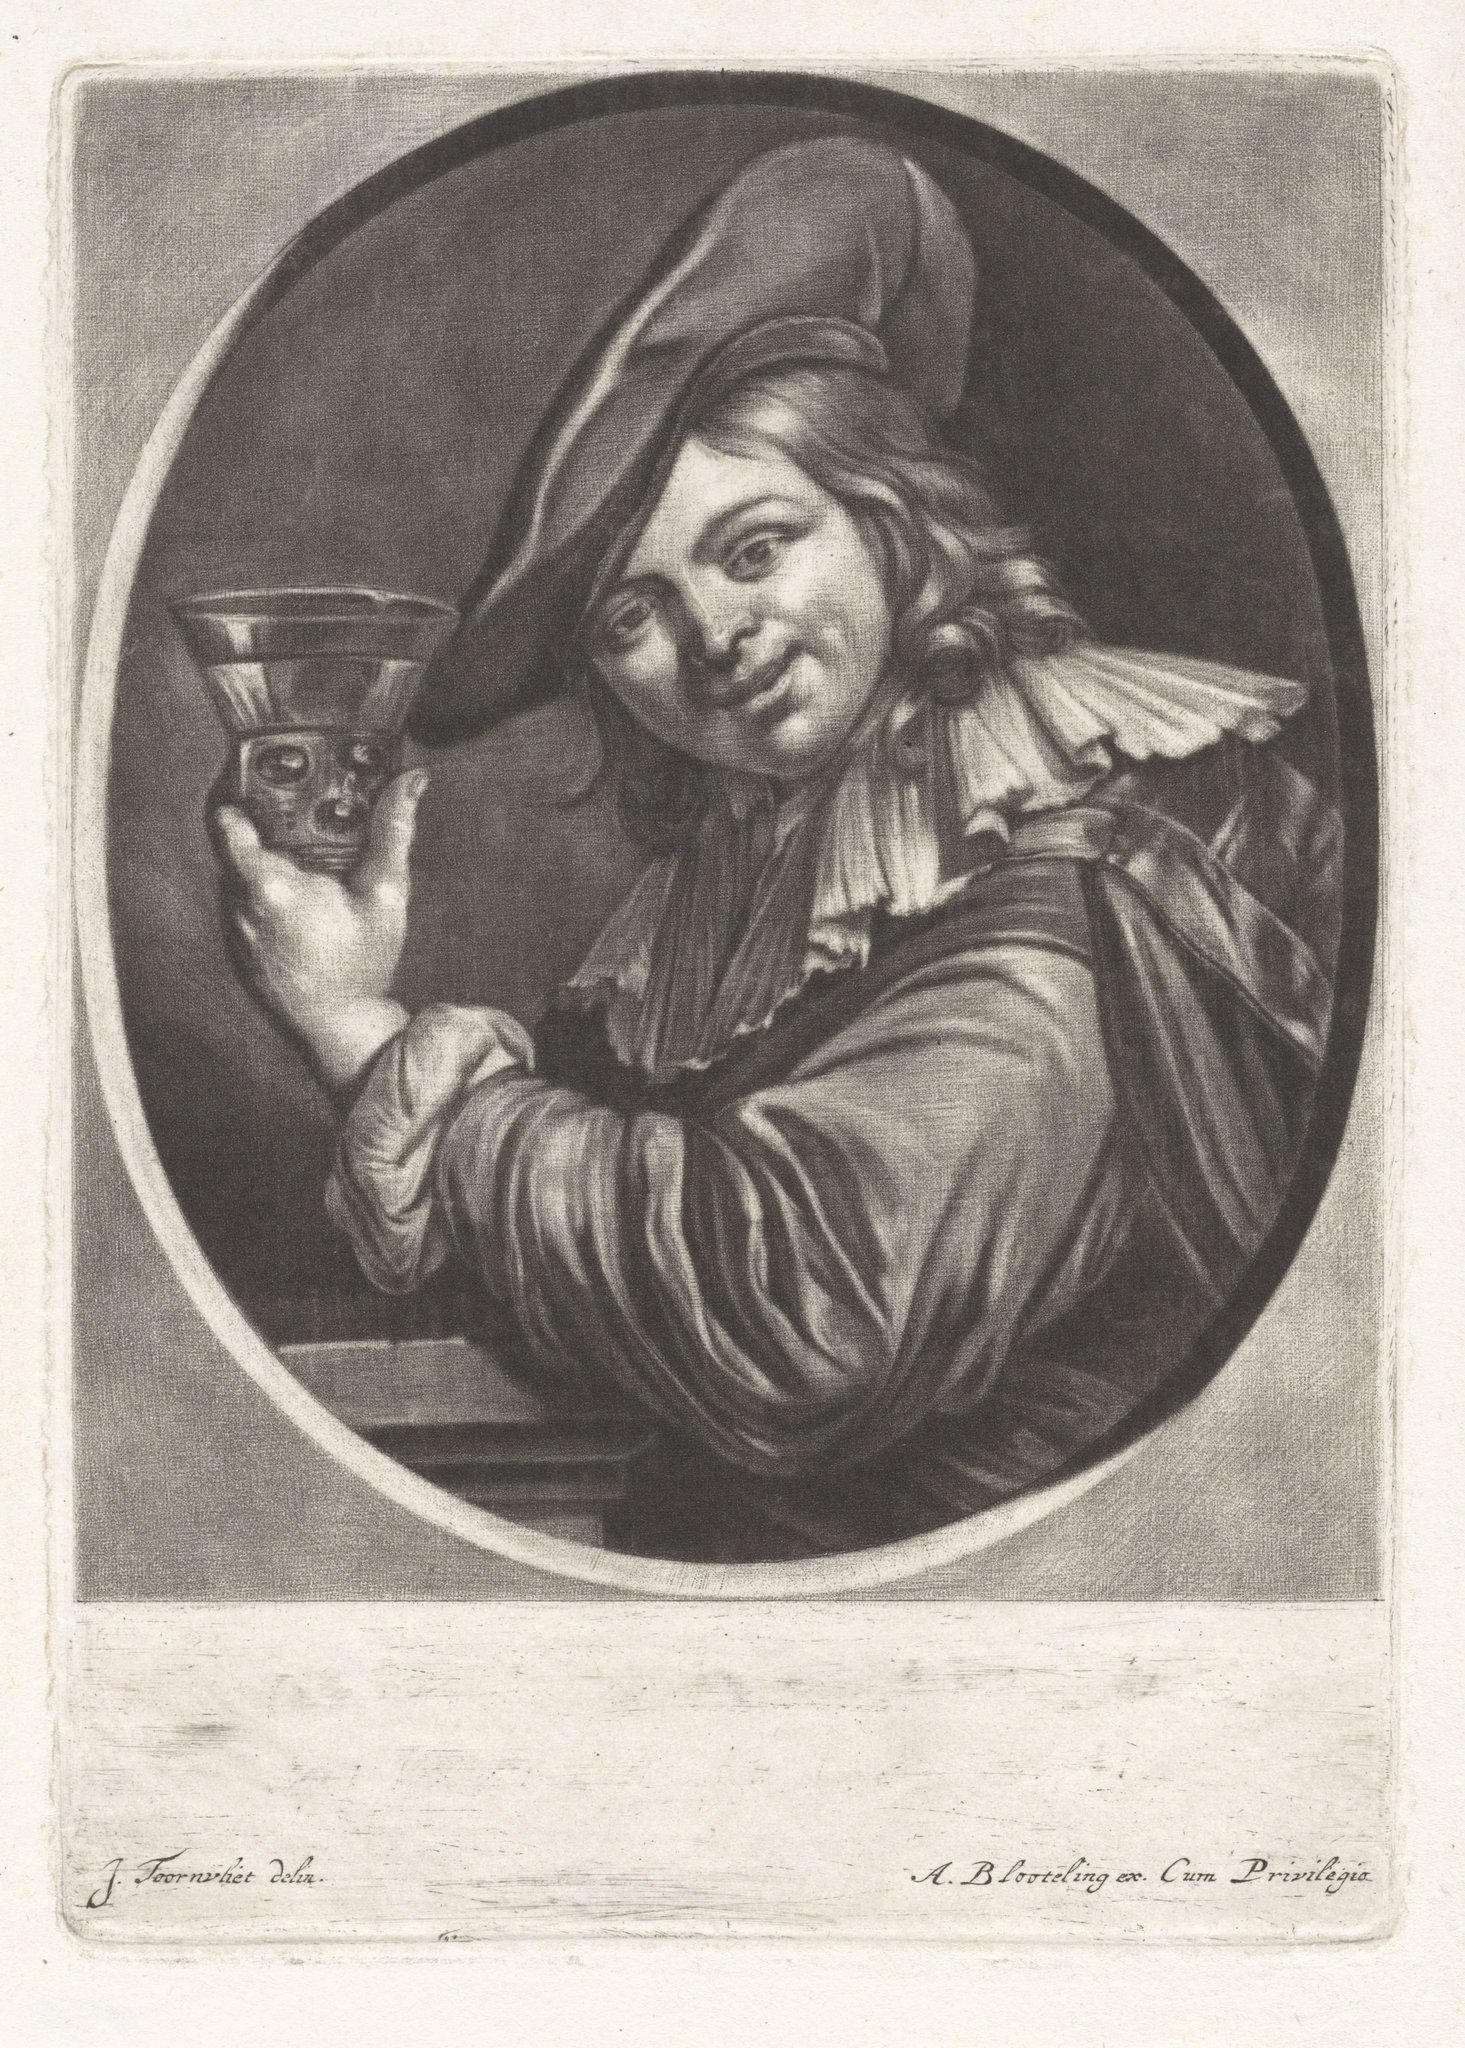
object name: print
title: Jonge man met een roemer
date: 1652-1690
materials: paper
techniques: engraving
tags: glass, rummer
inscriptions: collector's mark: Lugt 2228